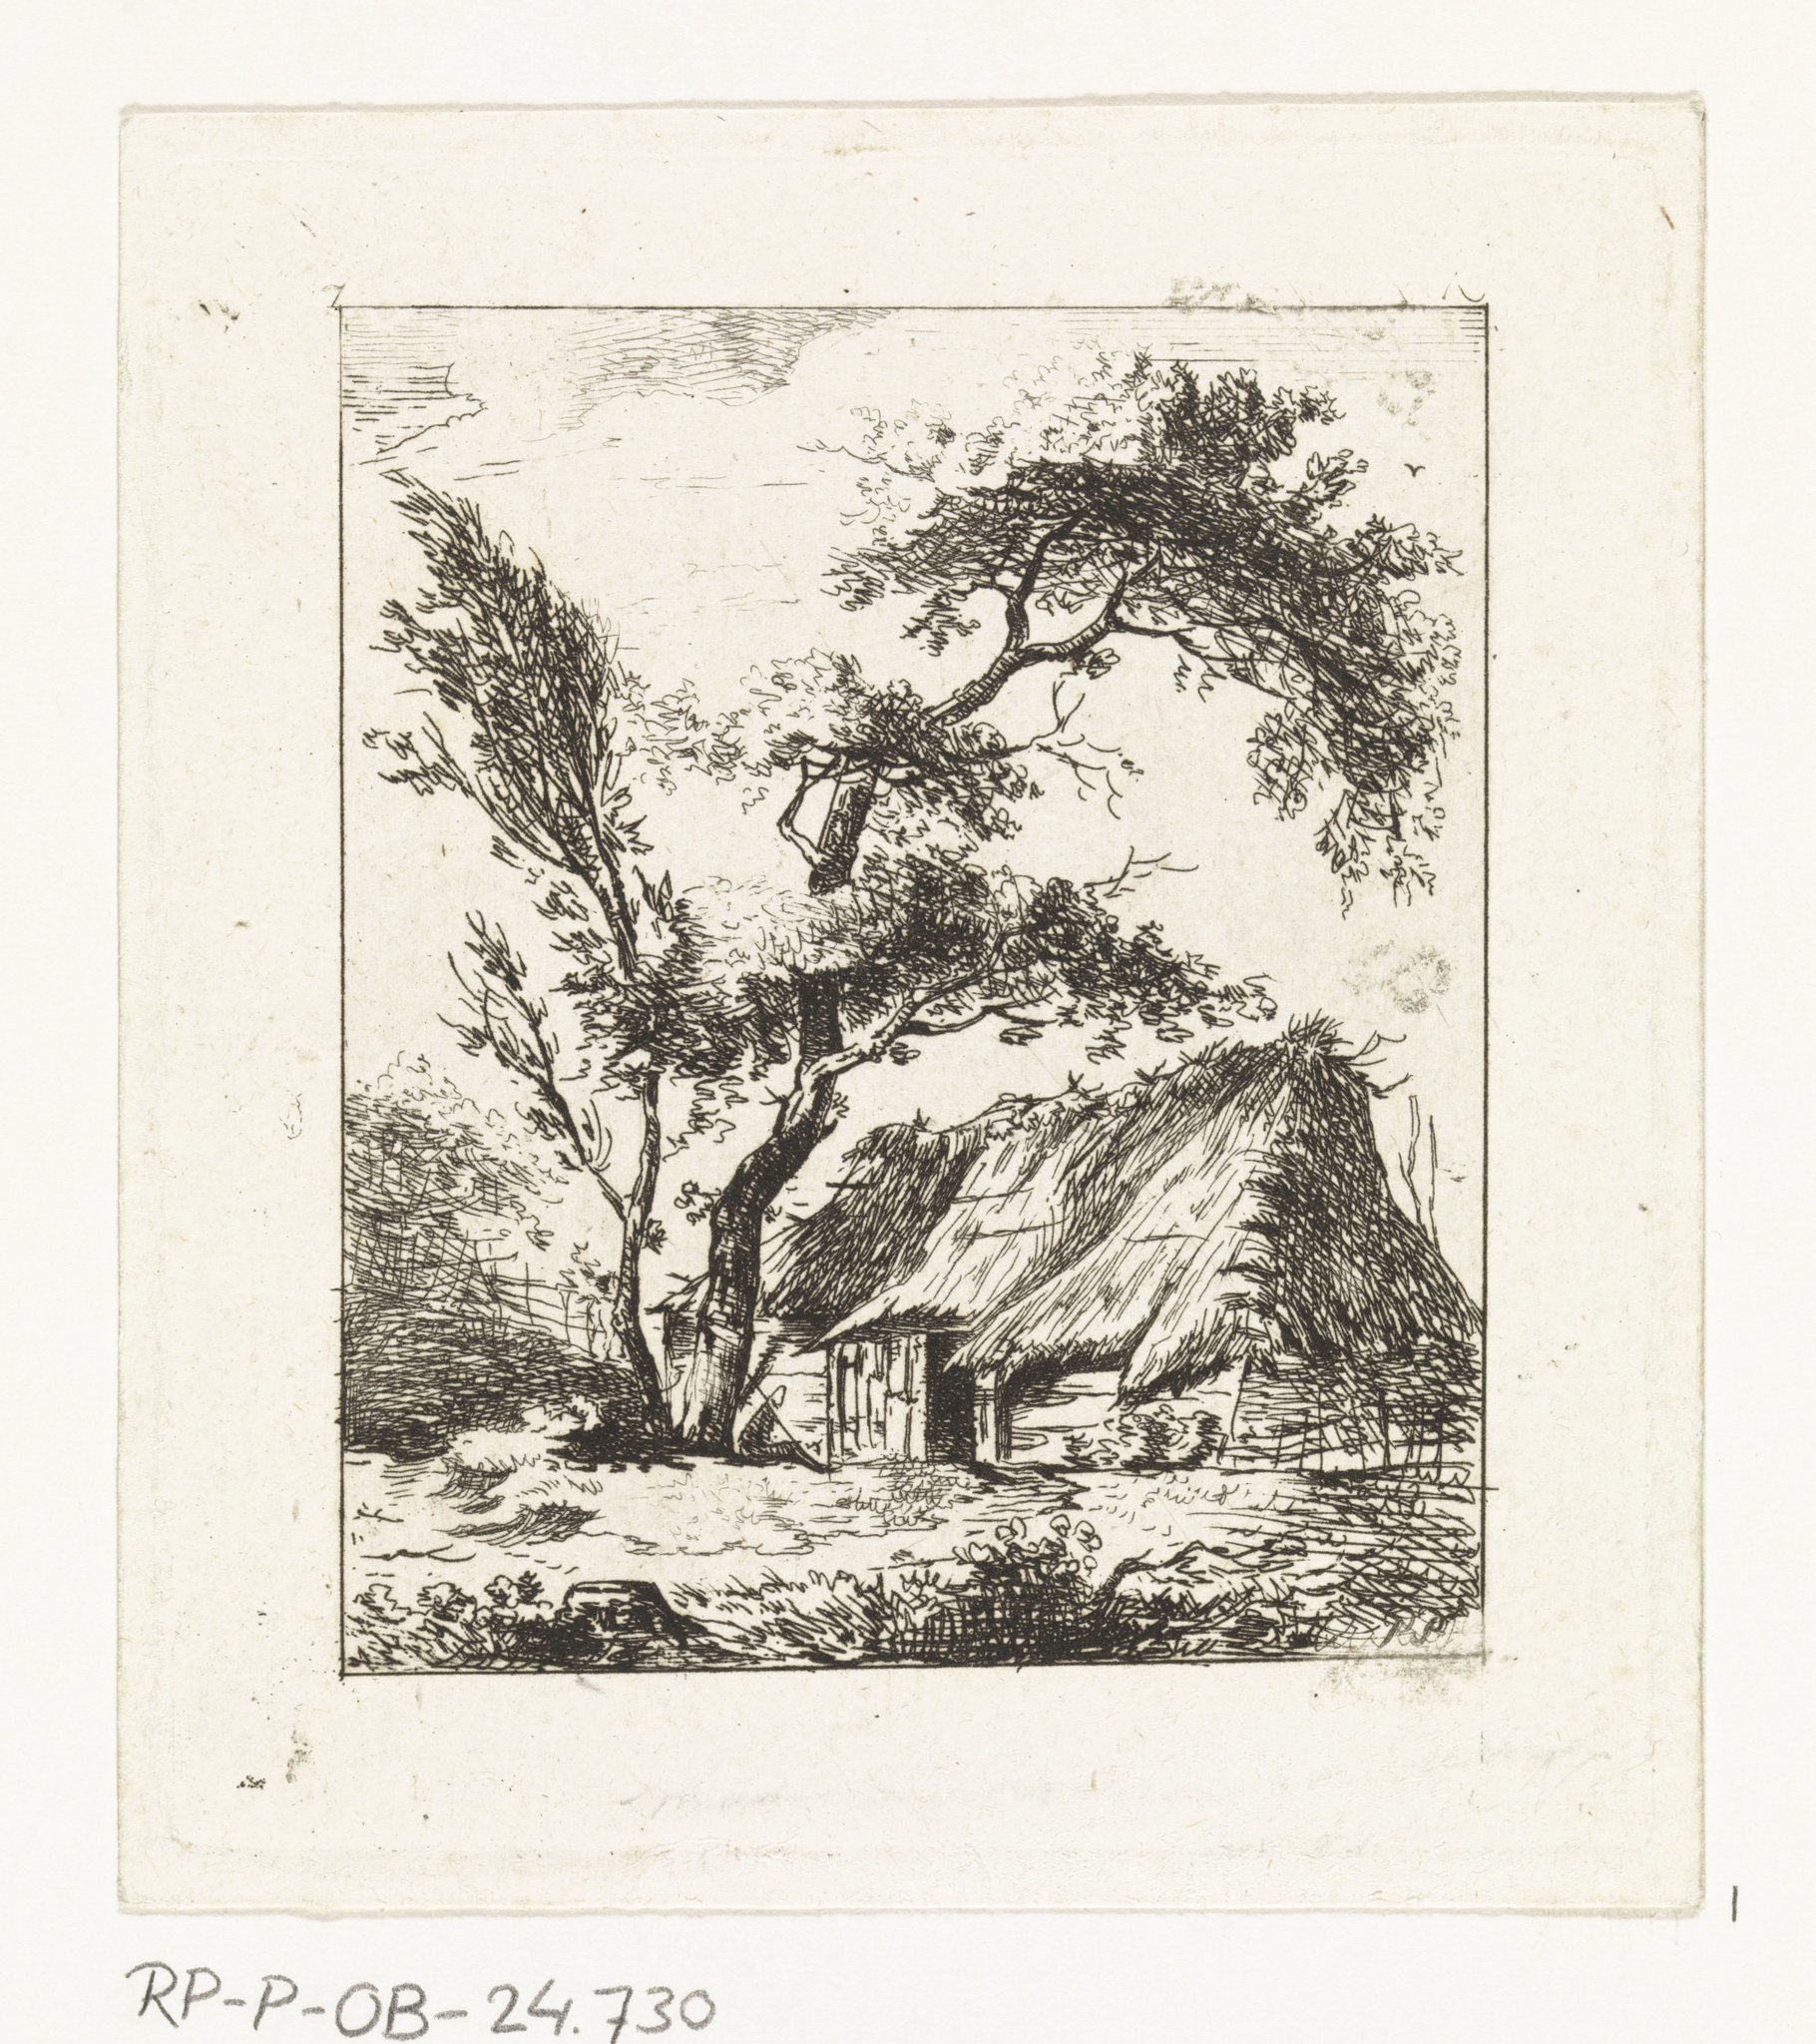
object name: print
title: Hut onder een boom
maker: paulus charles gerard poelman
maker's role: draughtsman, painter, print maker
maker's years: 1792-1846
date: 1803-1846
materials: paper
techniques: etching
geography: utrecht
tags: garden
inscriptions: inscription: ‘Eerste proefdruk’, collector's mark: Lugt 2228